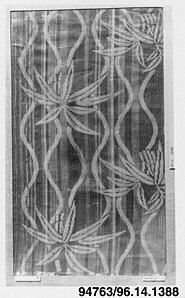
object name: textile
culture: japanese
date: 1701-1900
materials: silk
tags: leaves